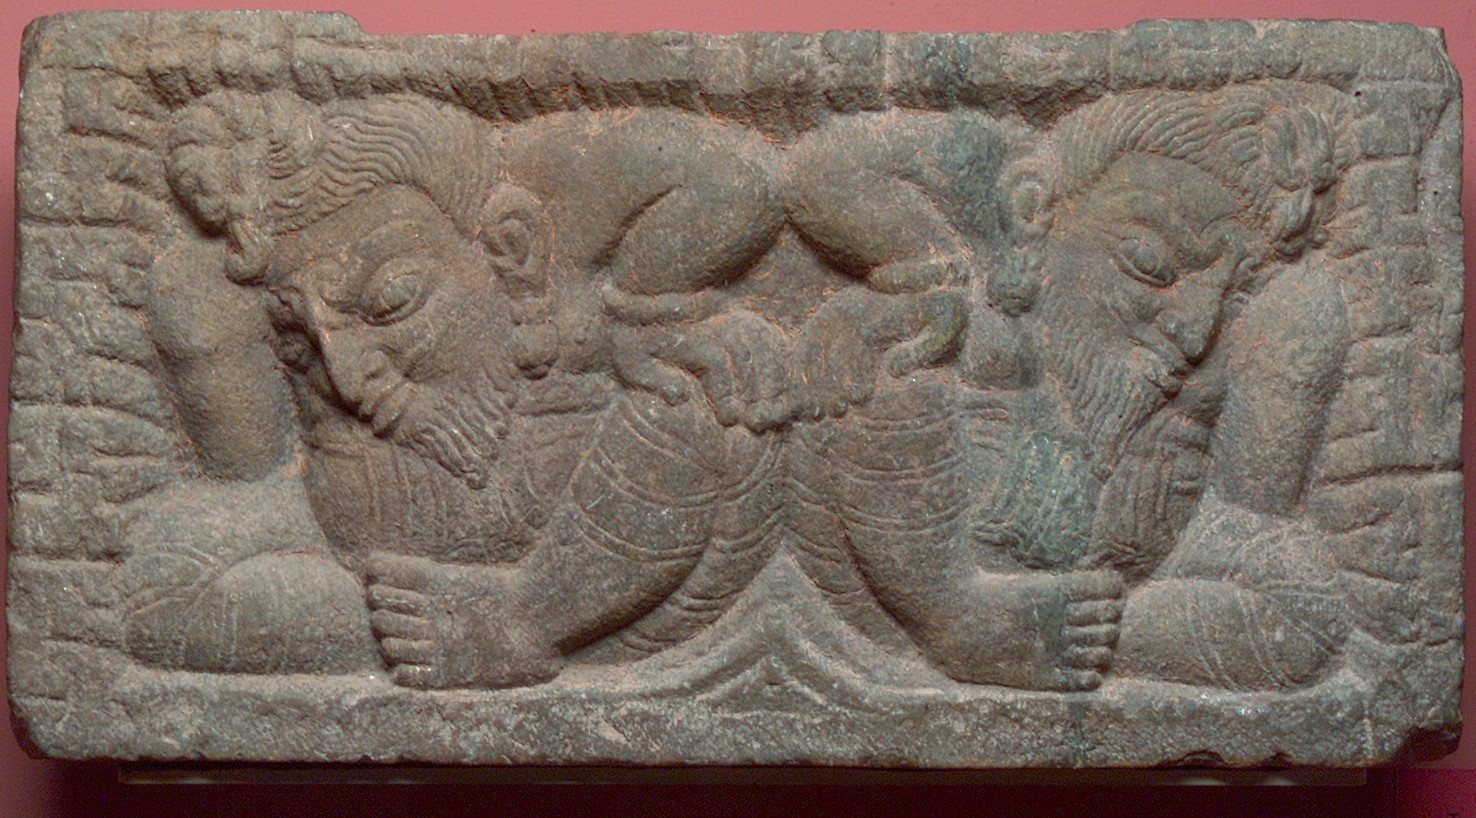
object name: panel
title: Yakshas Relief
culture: nepali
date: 701-900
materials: stone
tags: men